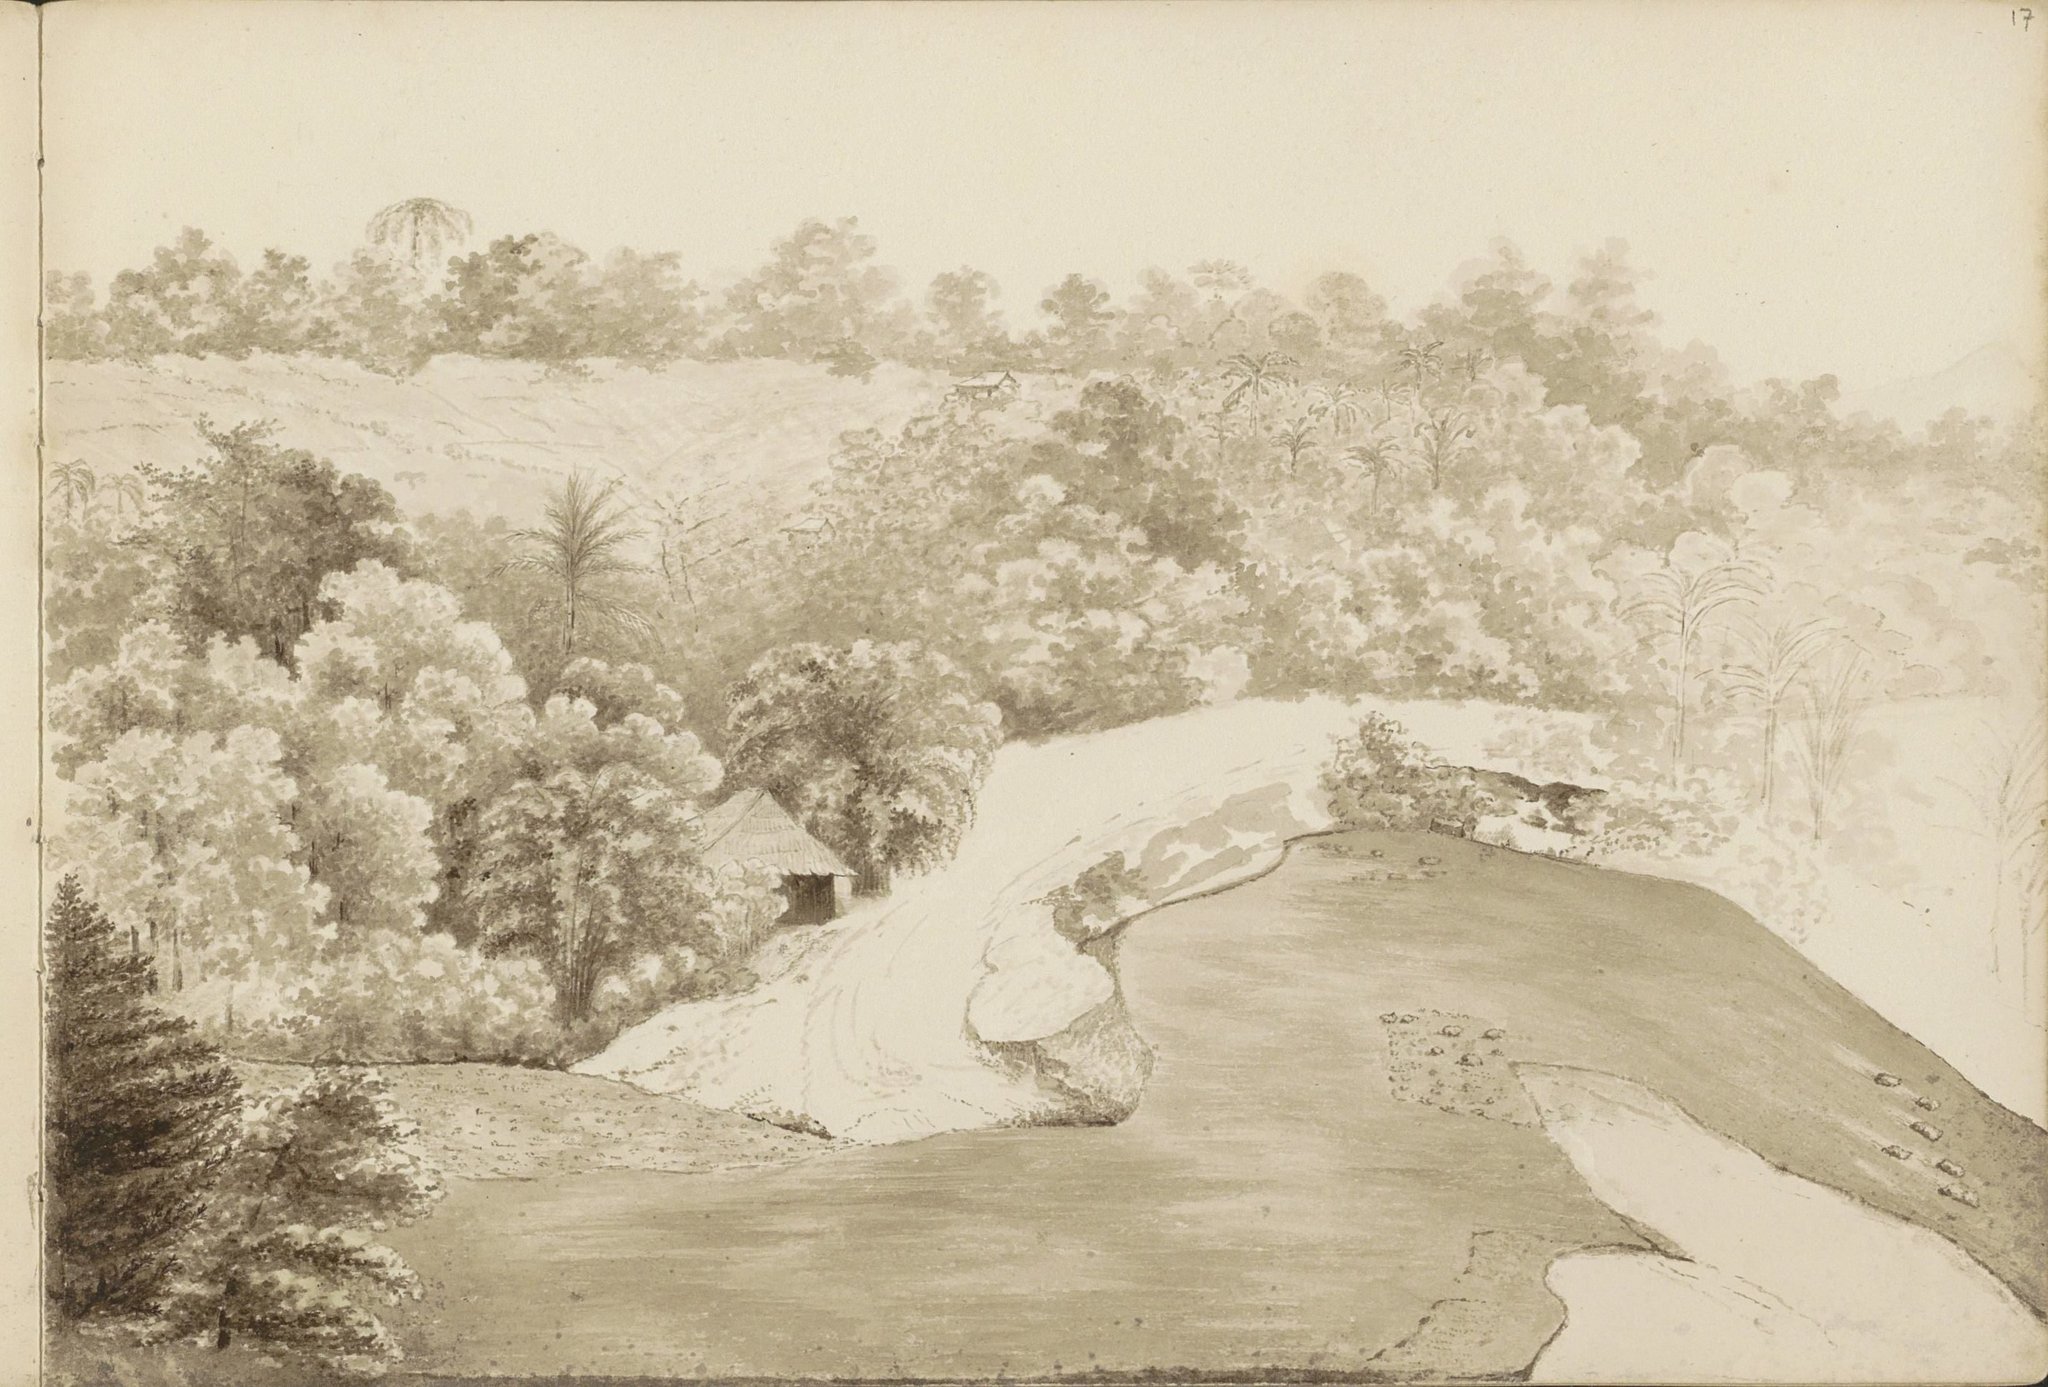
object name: sketchbook leaf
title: Landschap met palmbomen, vermoedelijk te Nederlands-Indië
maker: Anonymous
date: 1838-1865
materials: paper, pencil, watercolor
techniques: brush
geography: dutch east indies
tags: landscapes, trees: palm-tree, hut, cabin, lodge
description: Blad 17 recto uit een schetsboek met 45 bladen.